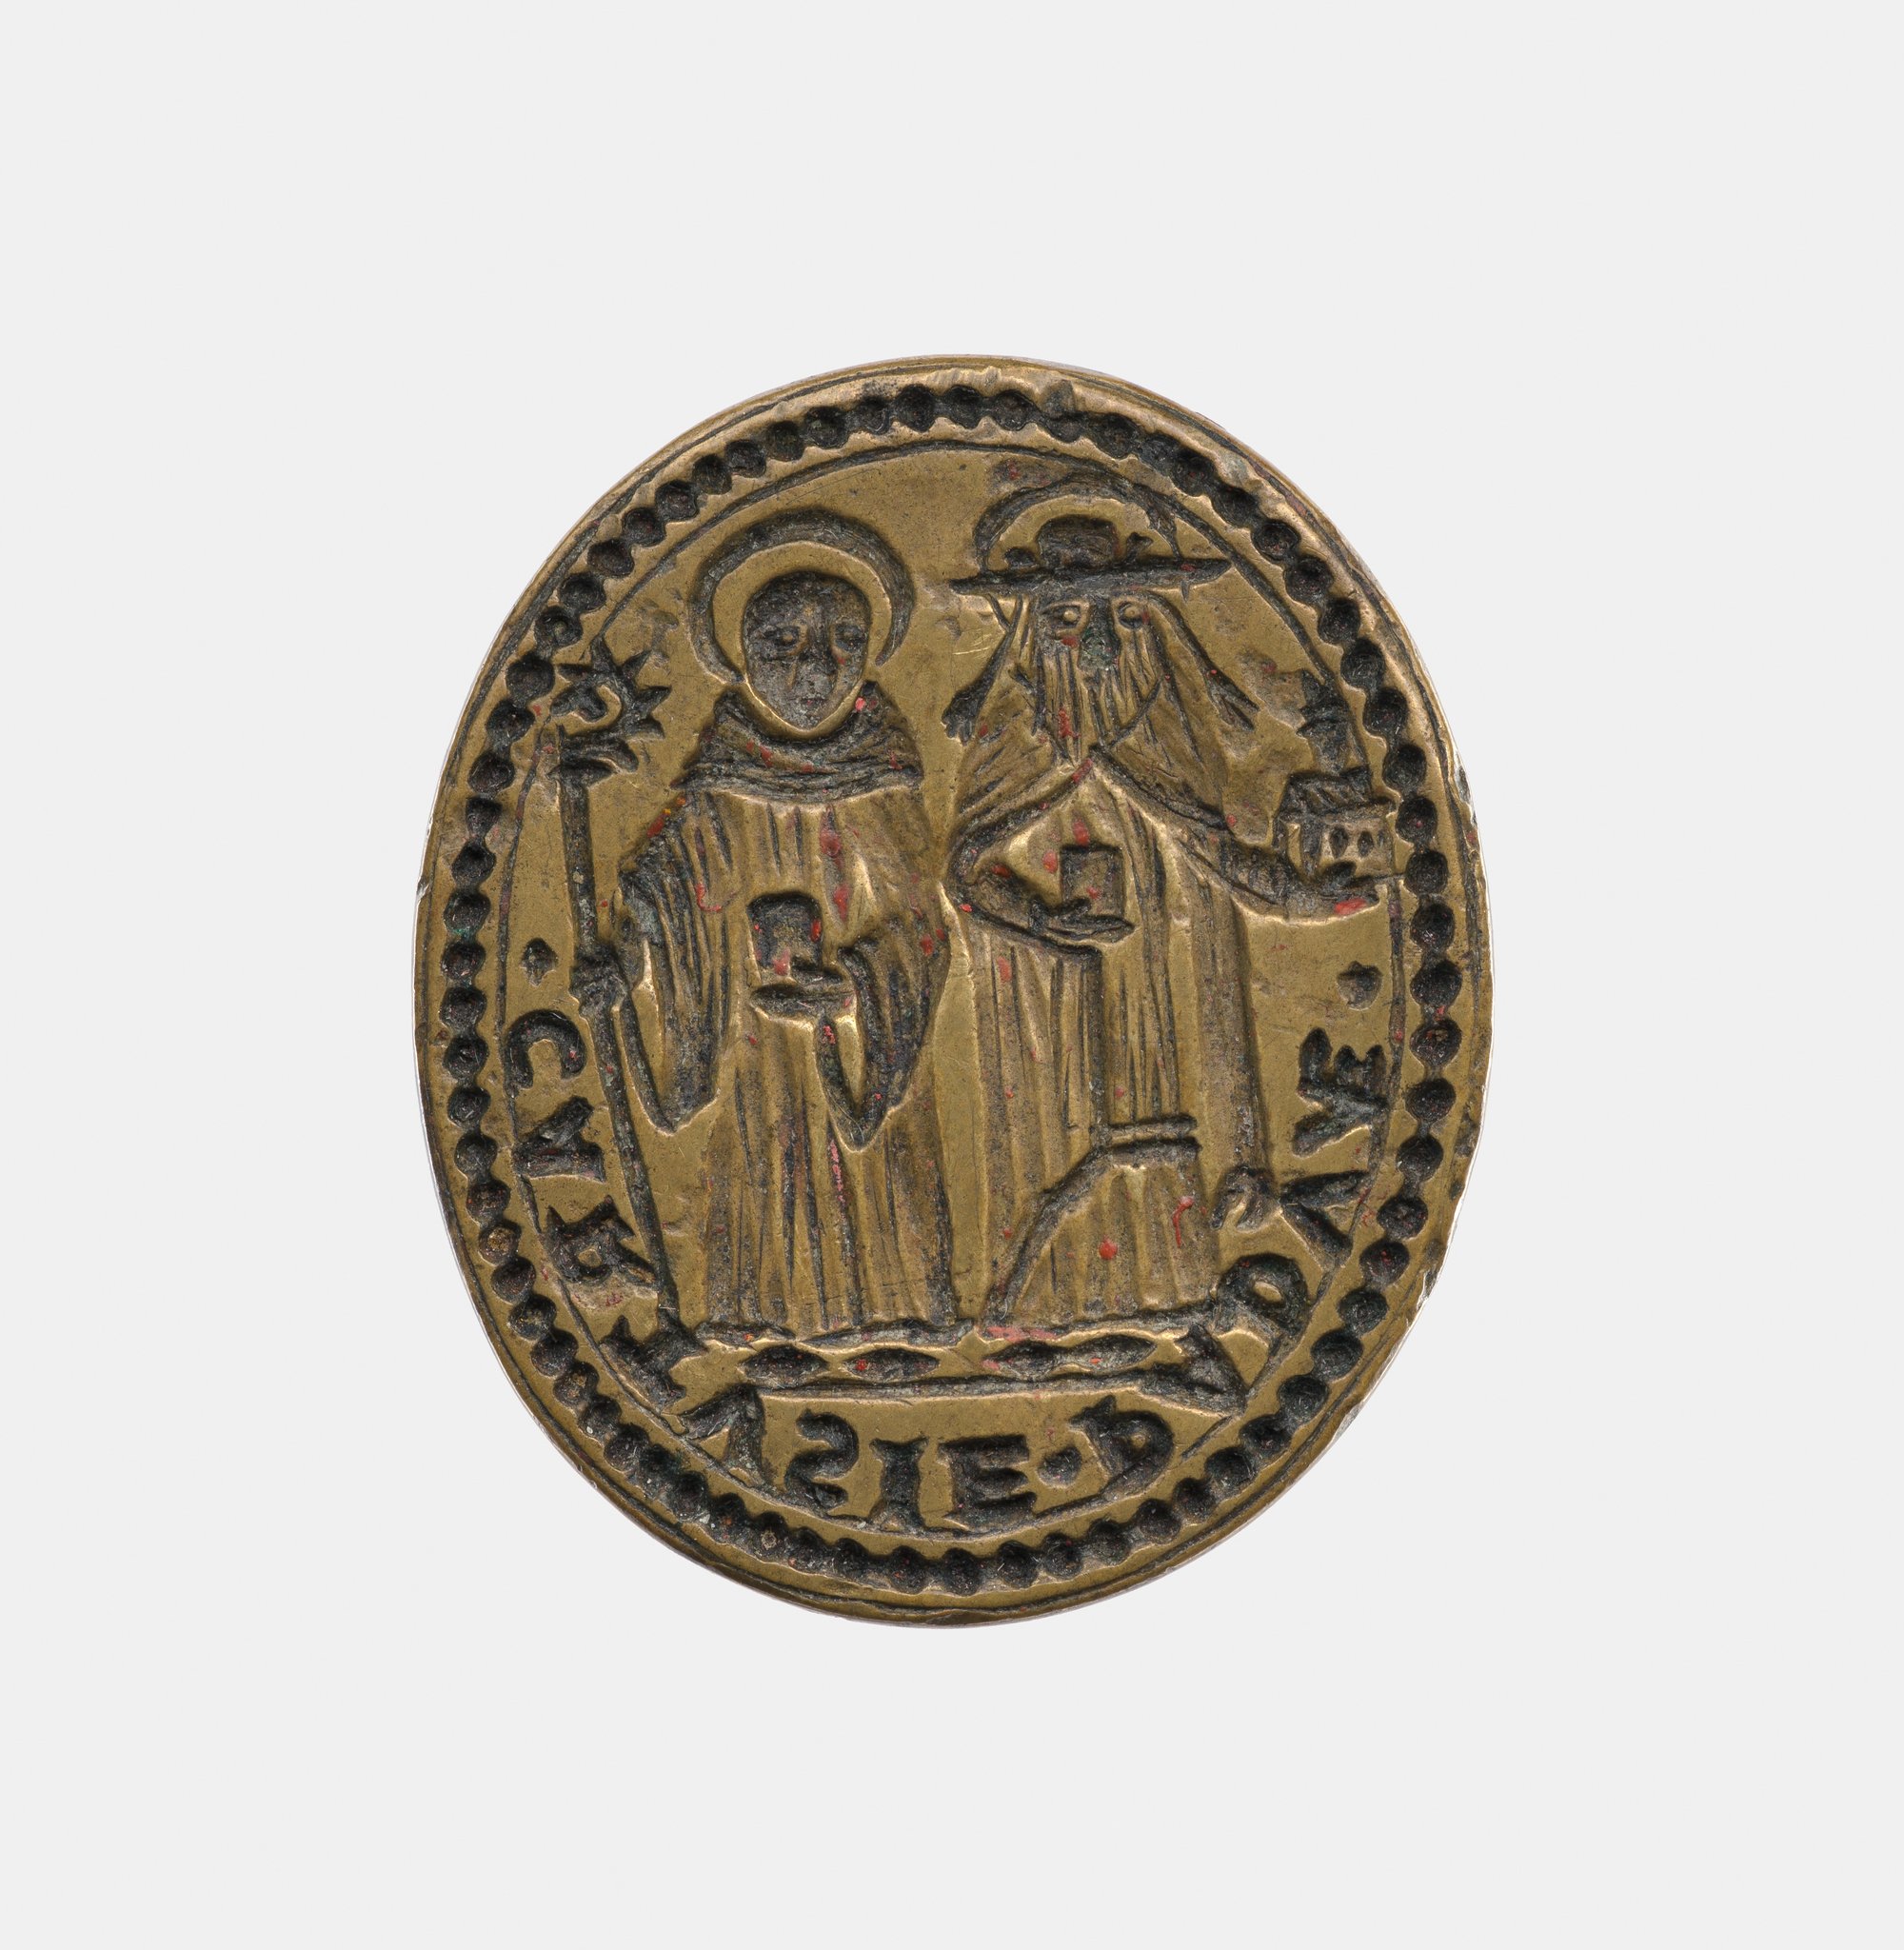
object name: stamp seal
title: Carthusian seal stamp with depiction of St. Bruno and St. Antony of Padua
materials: bronze